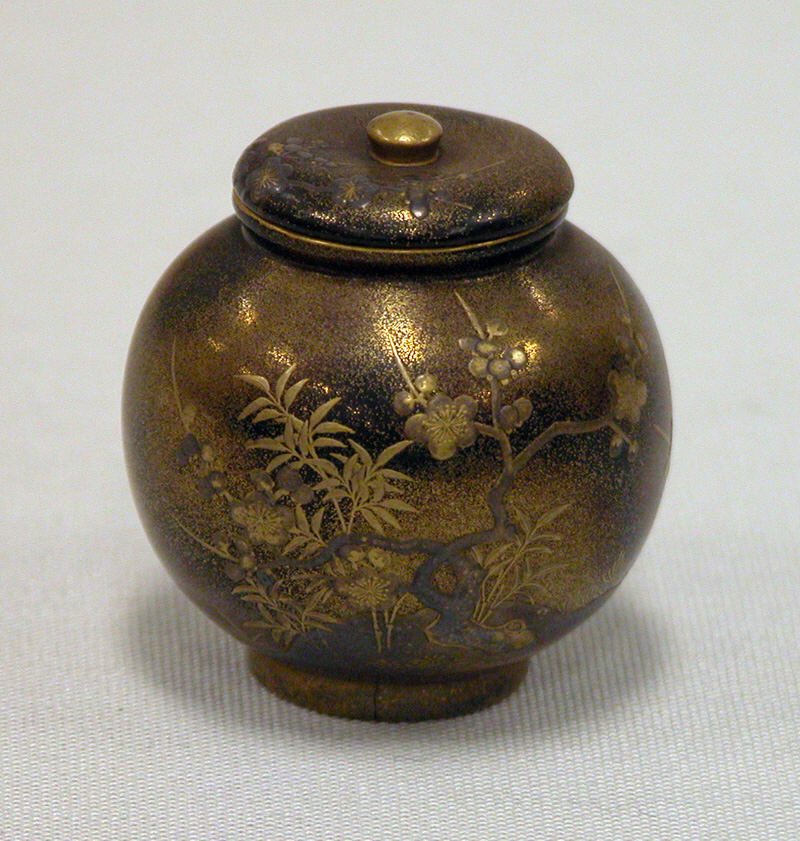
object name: water jar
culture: japanese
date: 1834-1866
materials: gold, lacquer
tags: flowers,plants